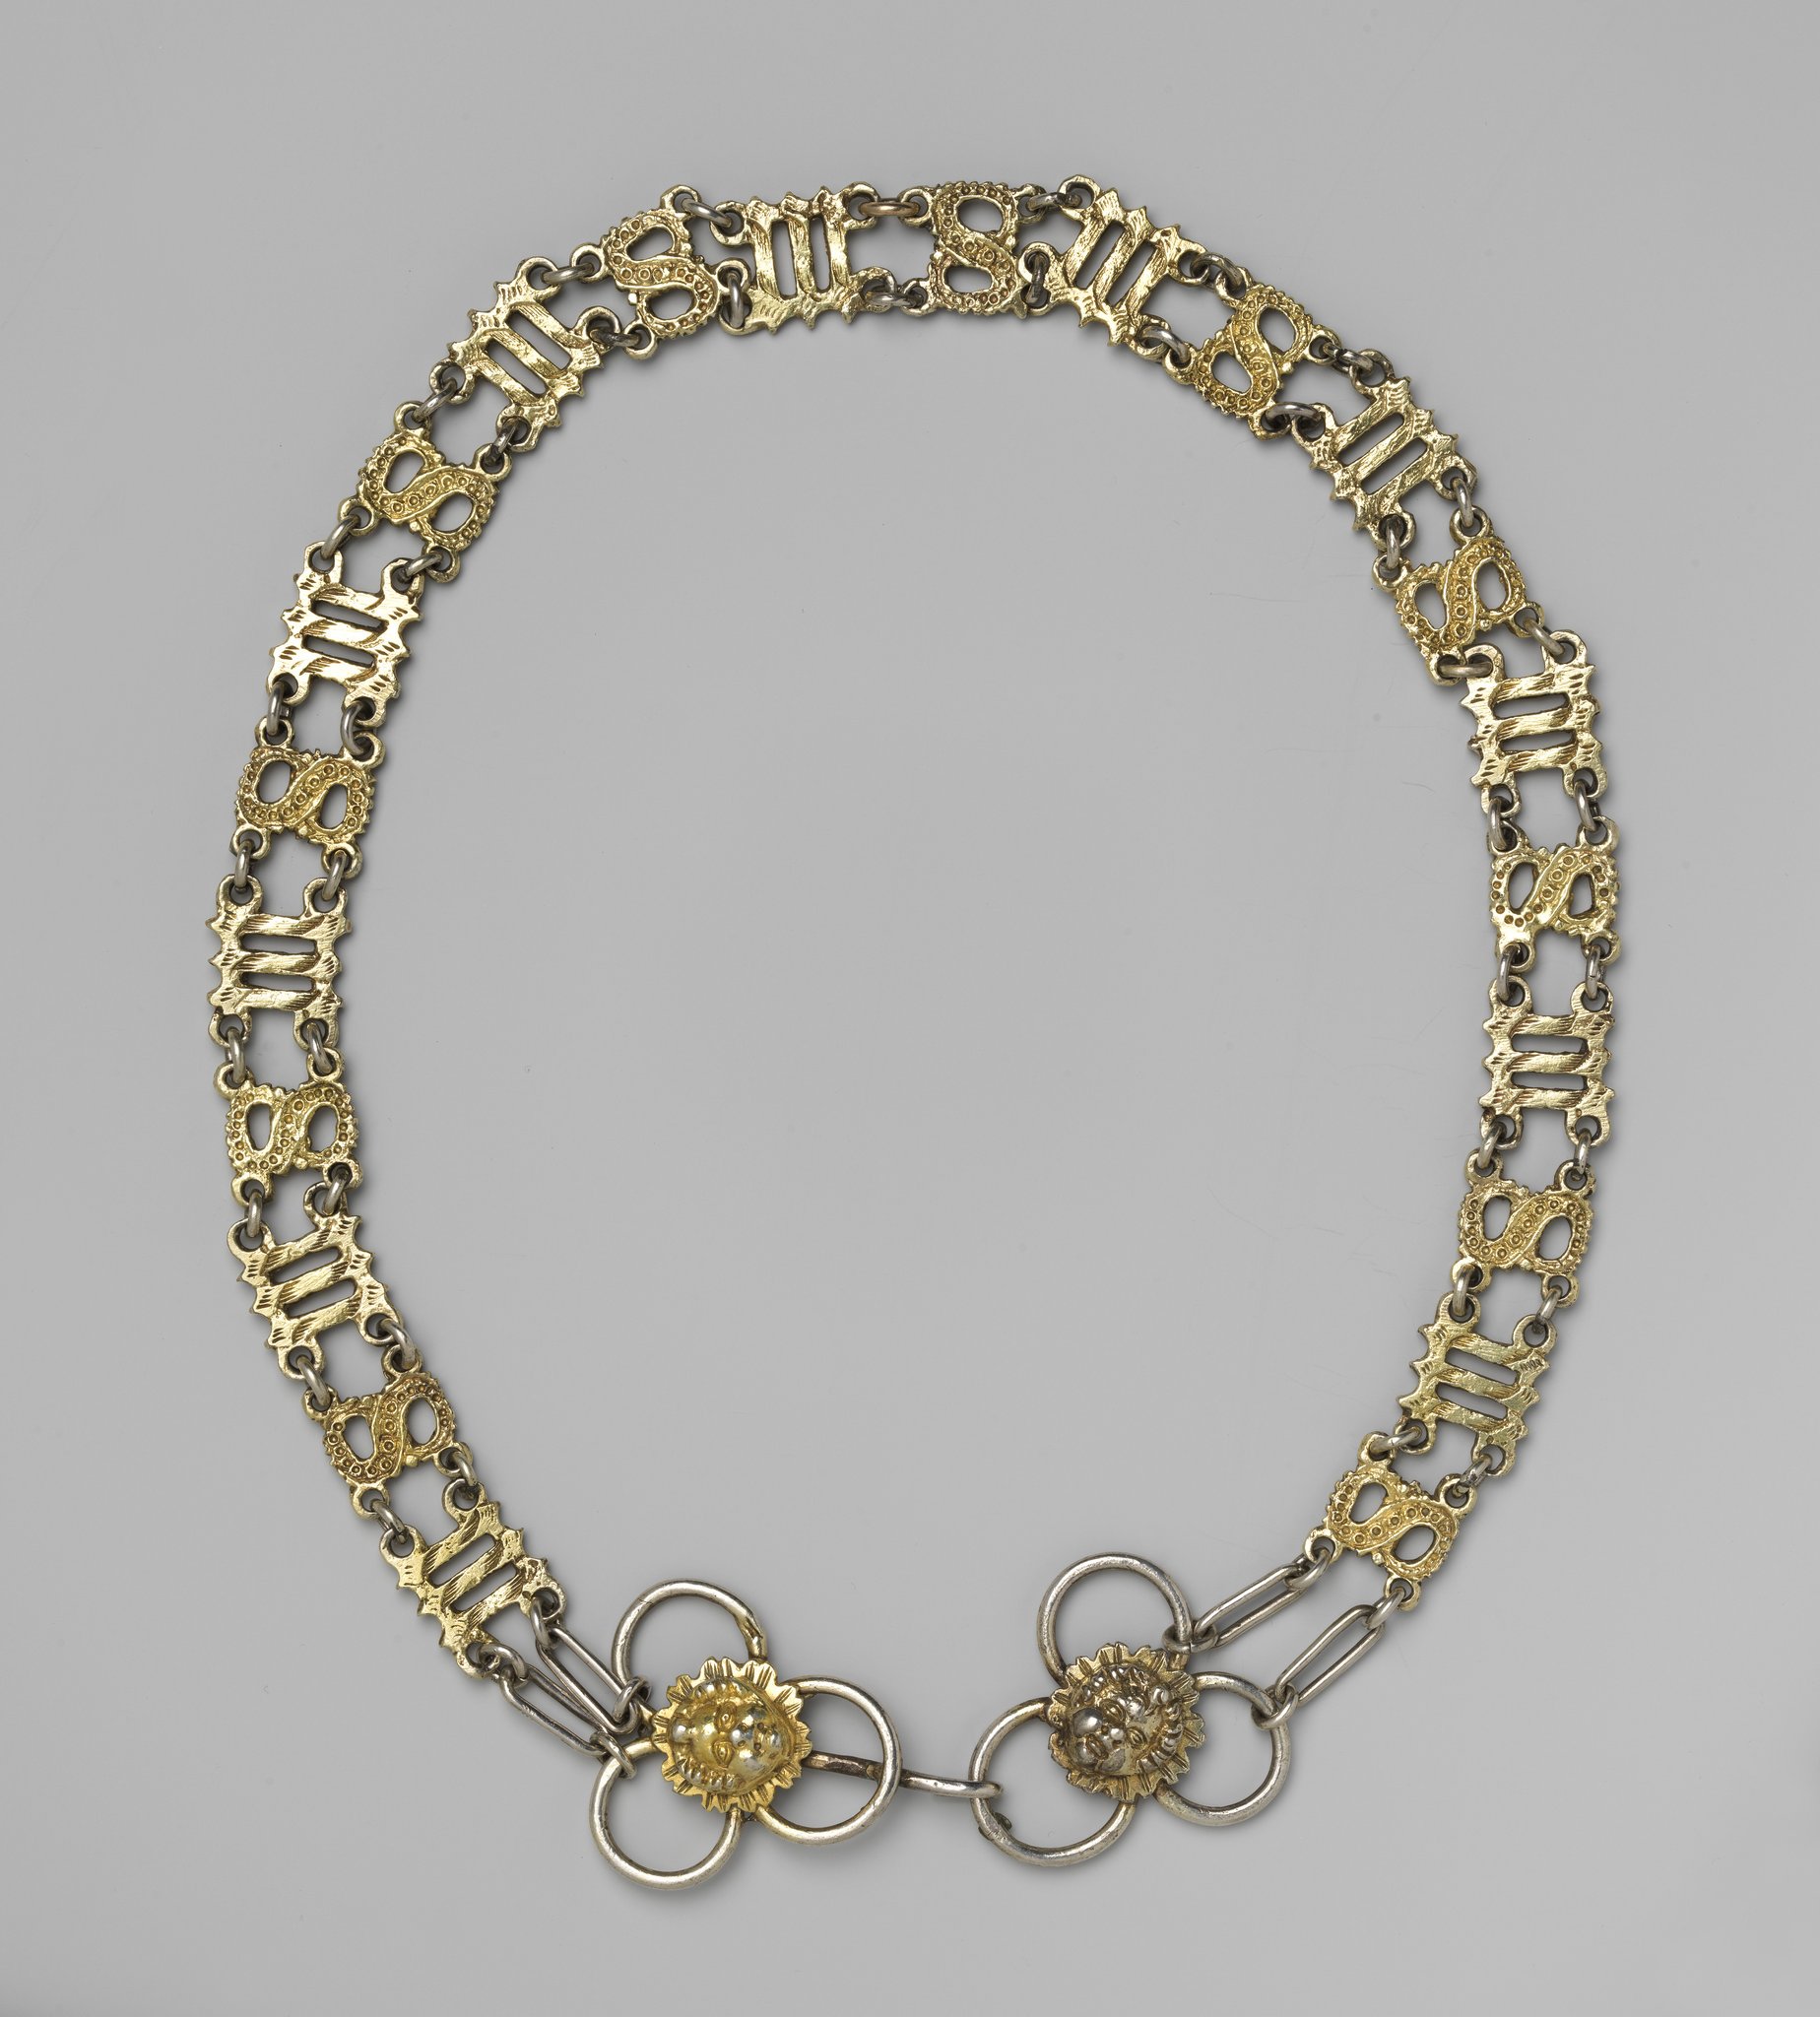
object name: collar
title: Collar composed of the Letters “S” and “M”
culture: british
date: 1401-1500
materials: silver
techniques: gilding